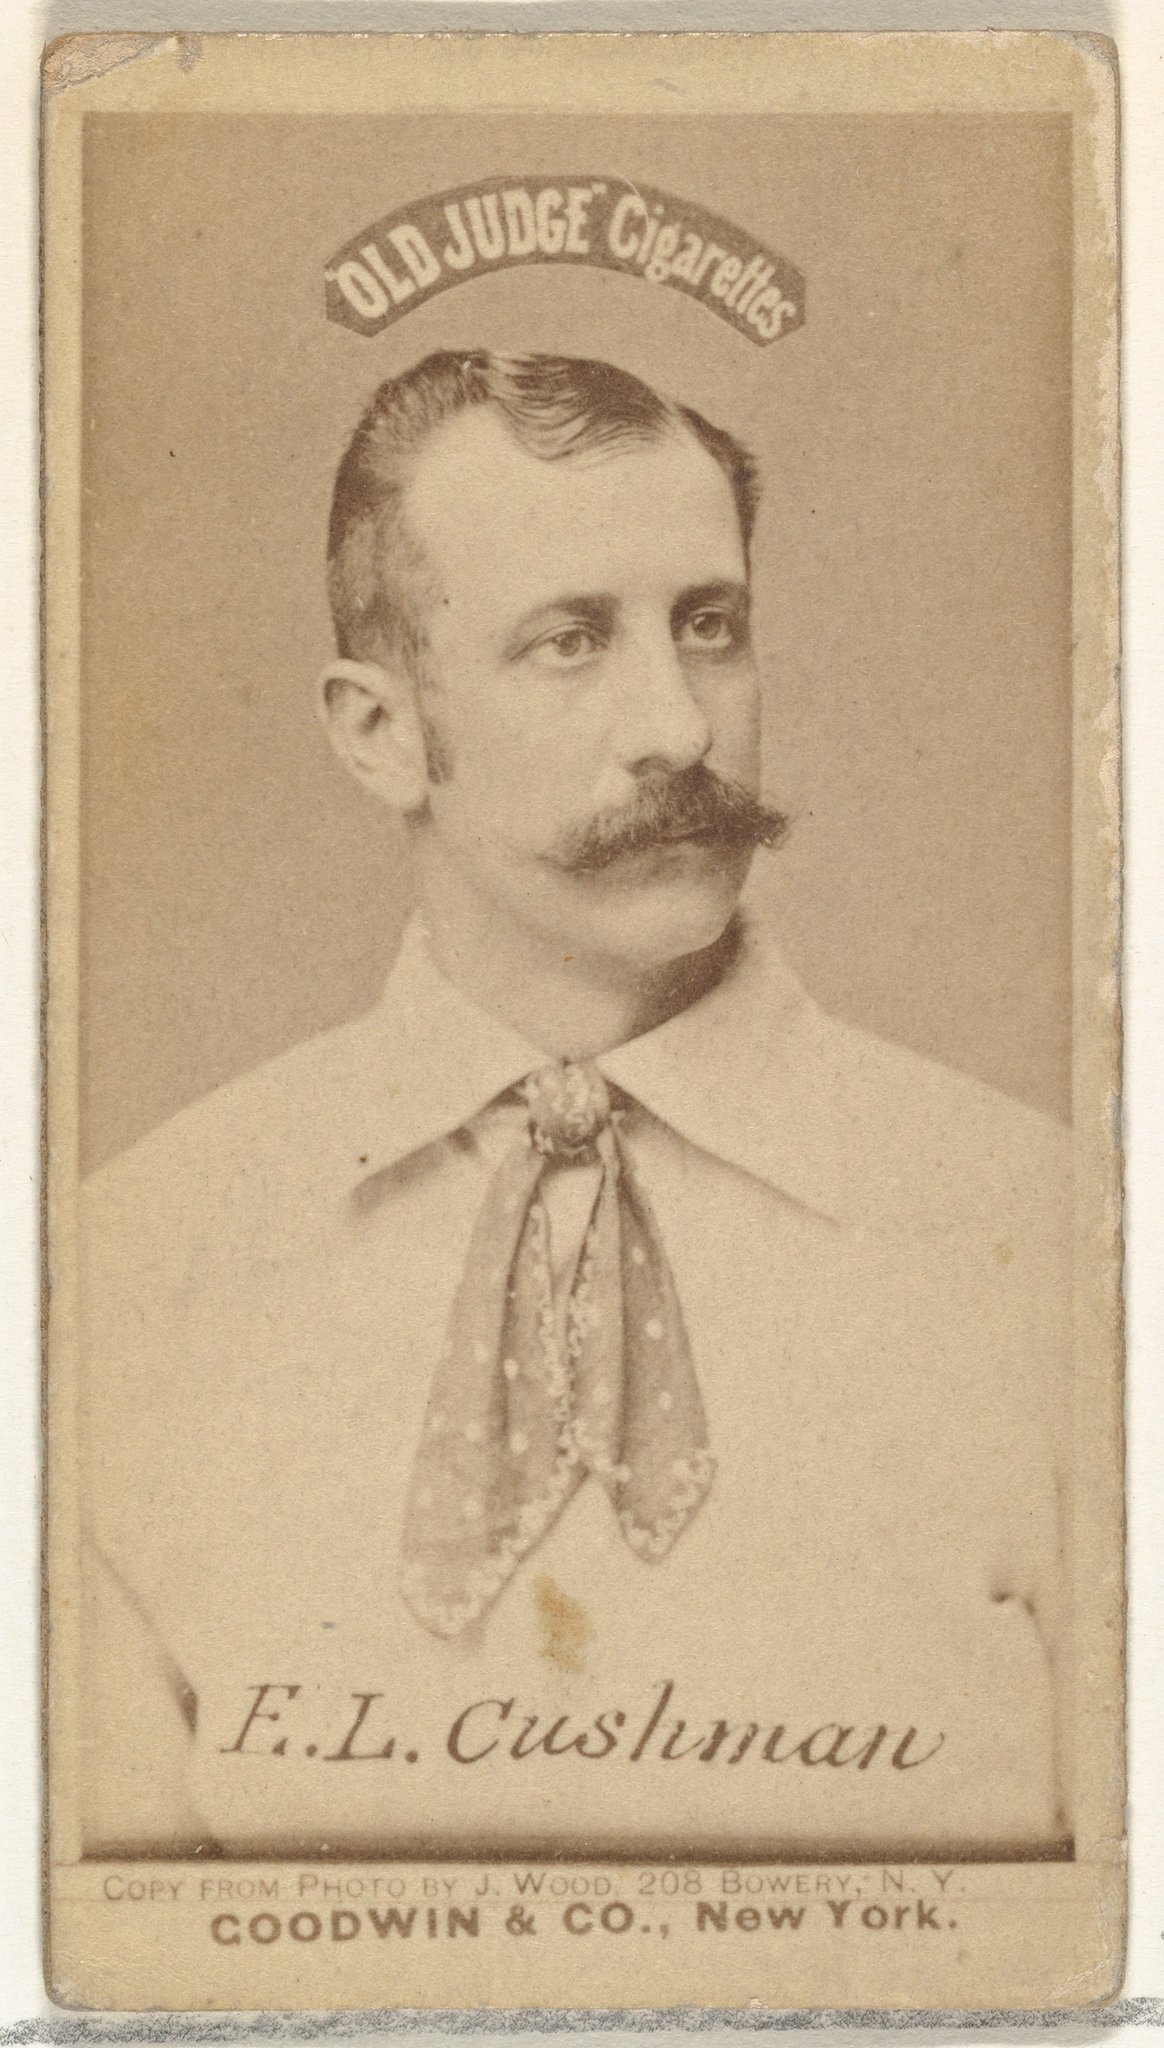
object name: baseball card, photograph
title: F.L. Cushman, from the Old Judge series (N172) for Old Judge Cigarettes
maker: goodwin & company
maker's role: publisher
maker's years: 1850-1950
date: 1887-1890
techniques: albumen silver print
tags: men,portraits,baseball,athletes